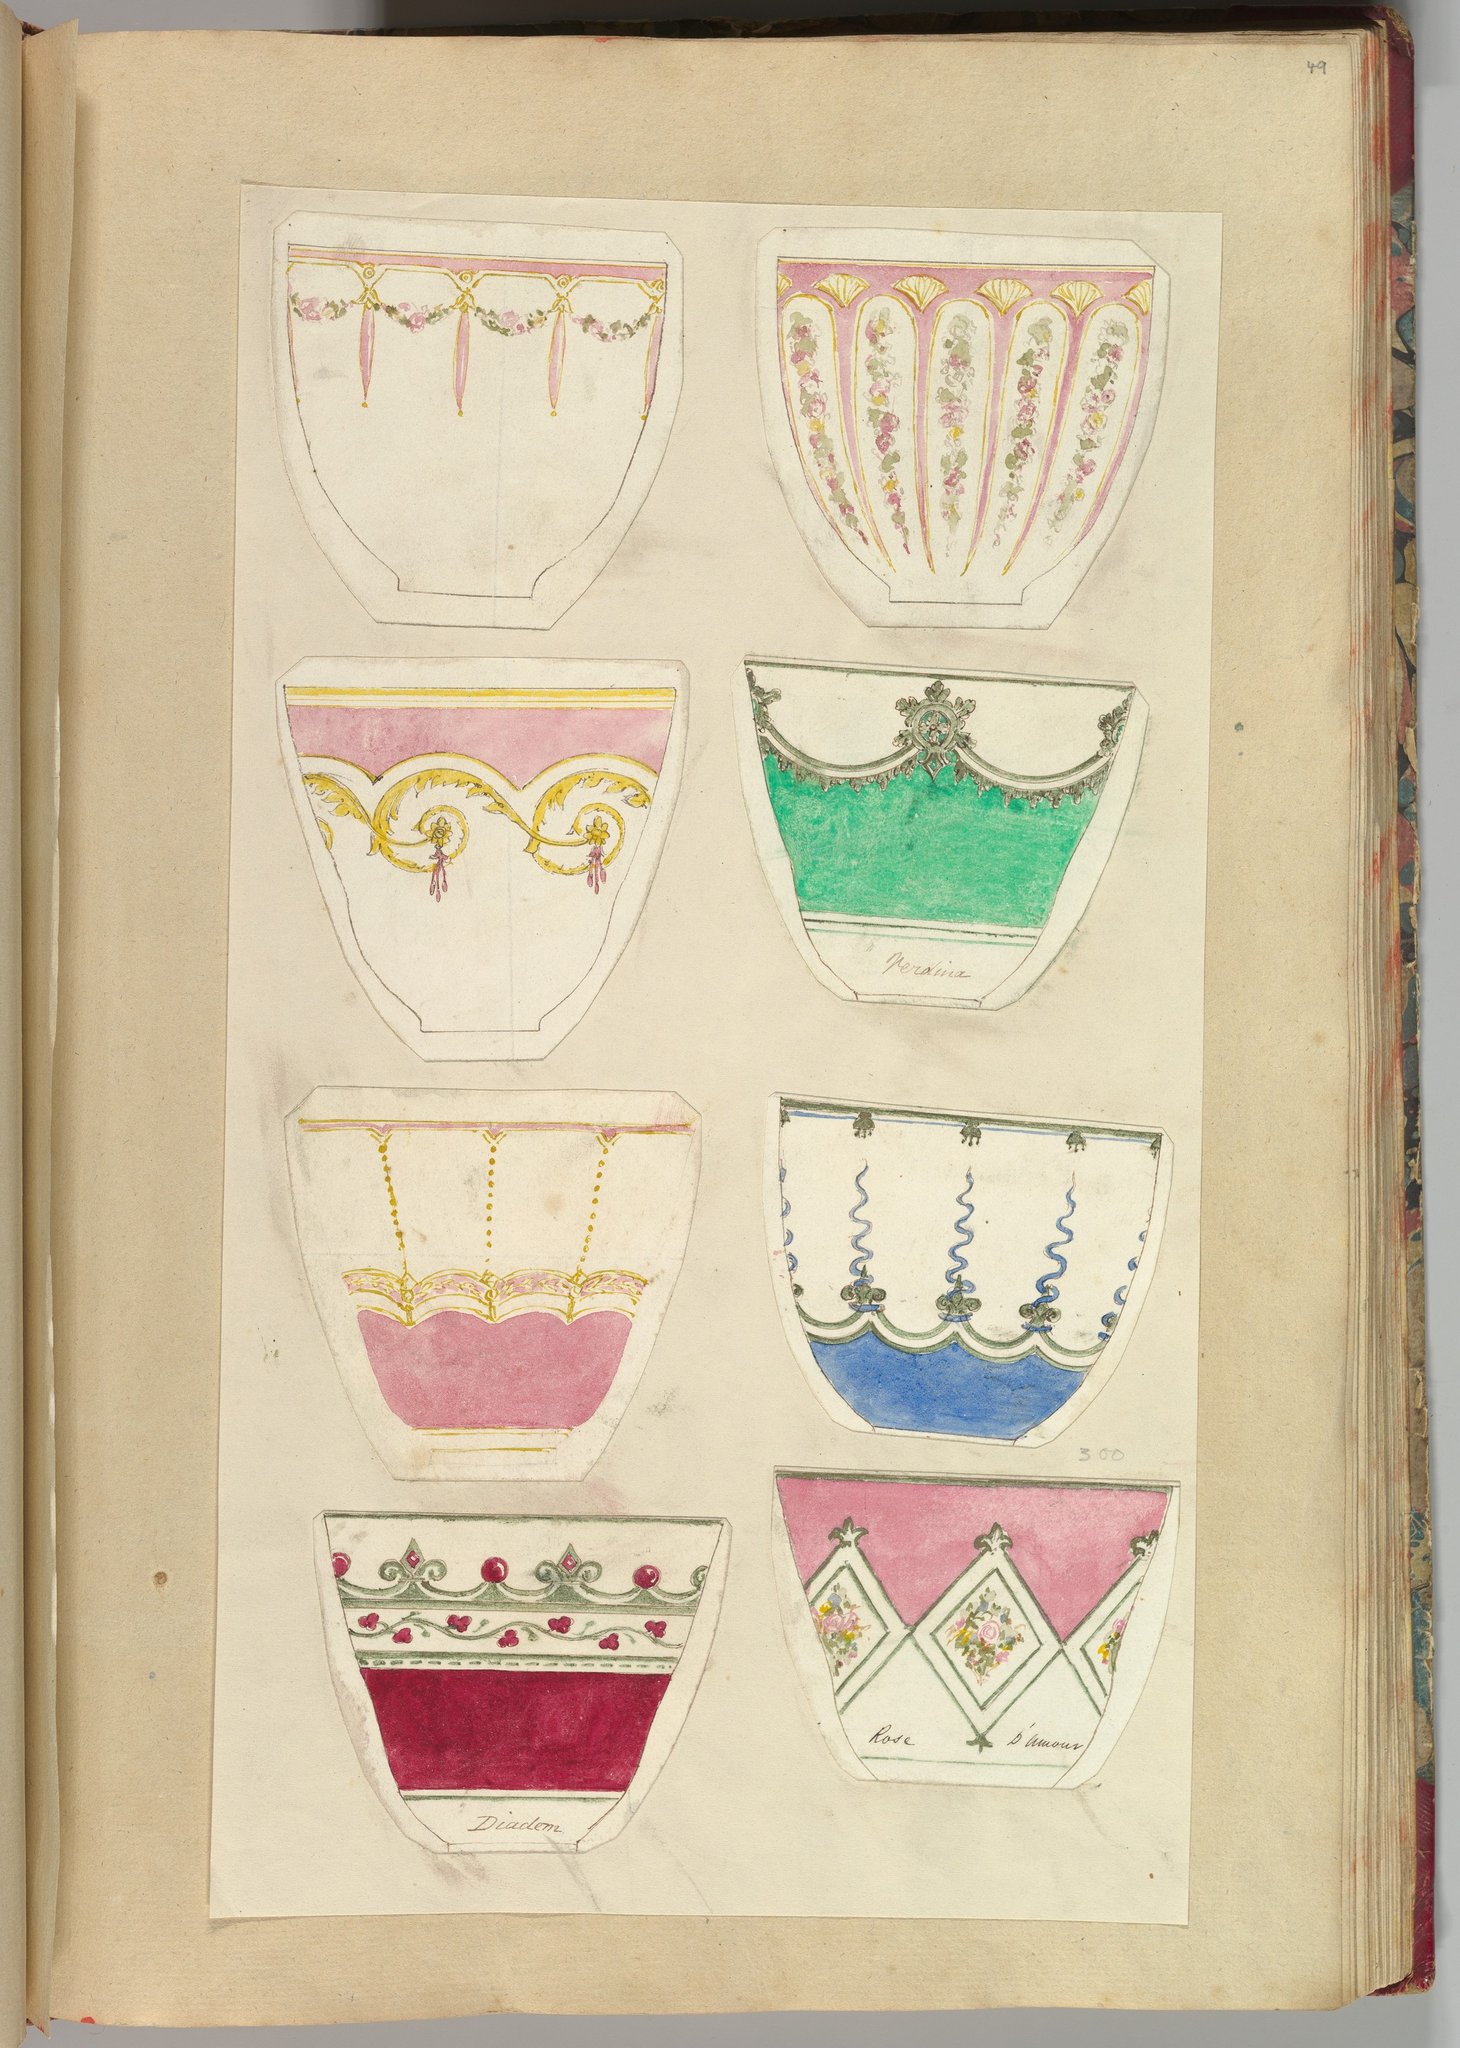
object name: drawing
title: Eight Designs for Decorated Cups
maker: alfred henry forrester [alfred crowquill]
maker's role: artist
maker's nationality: british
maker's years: 1804-1872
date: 1845-1855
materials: ink, watercolor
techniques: pen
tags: cups